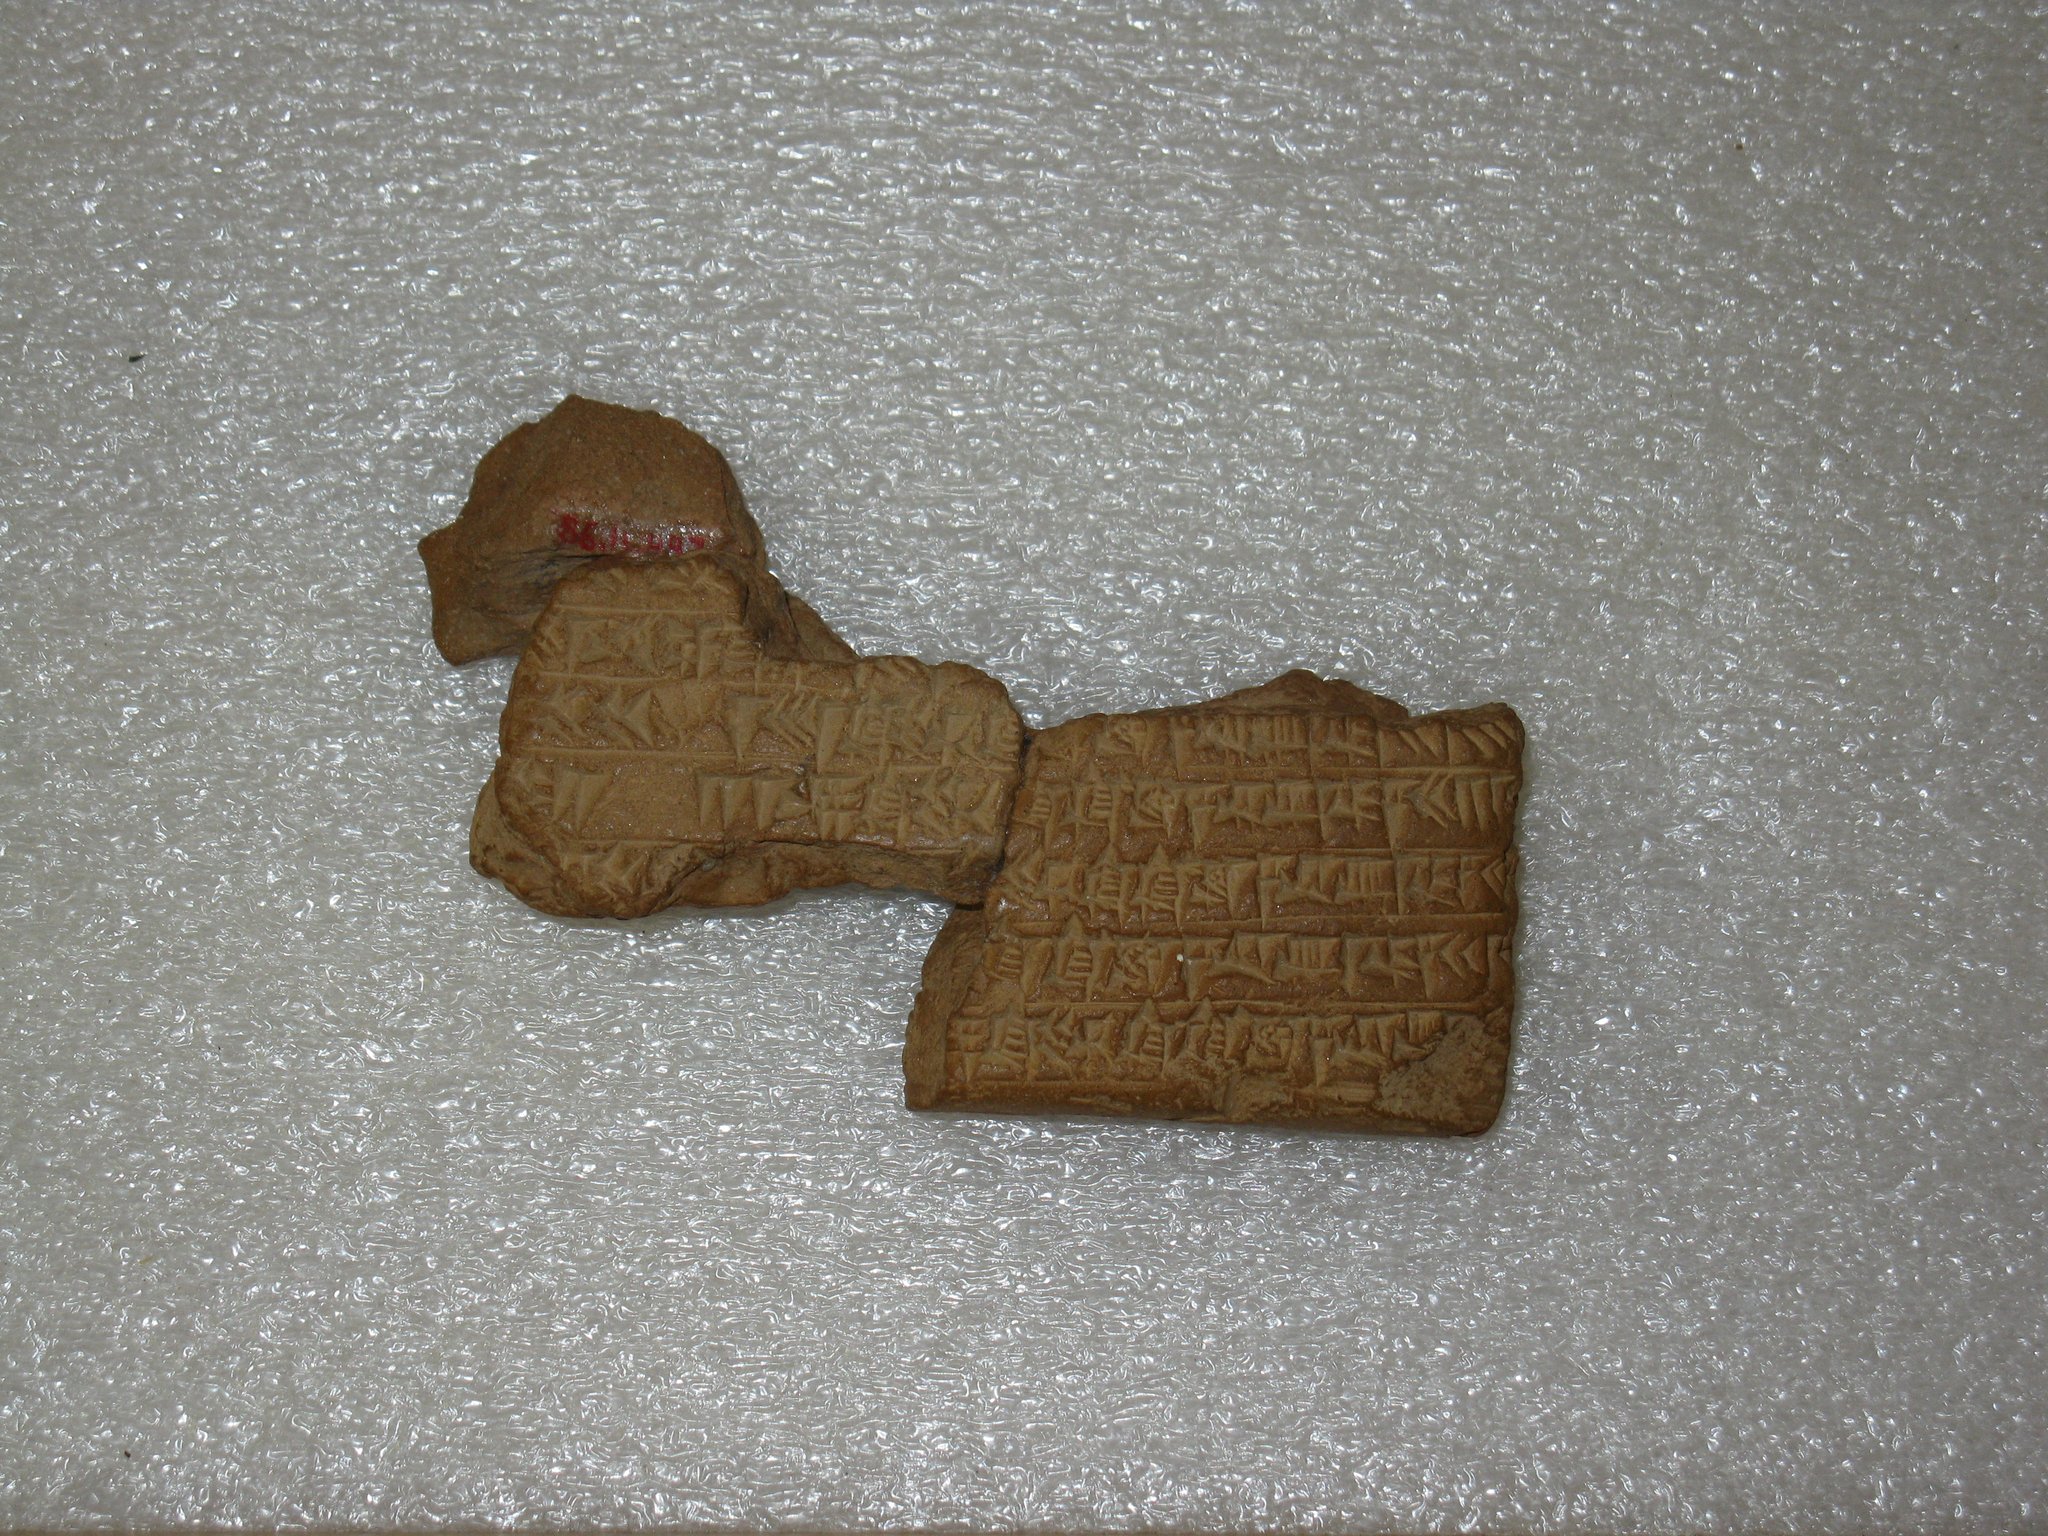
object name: cuneiform tablet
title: Cuneiform tablet: lunar procedure text (?)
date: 333-1 BCE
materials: clay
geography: mesopotamia